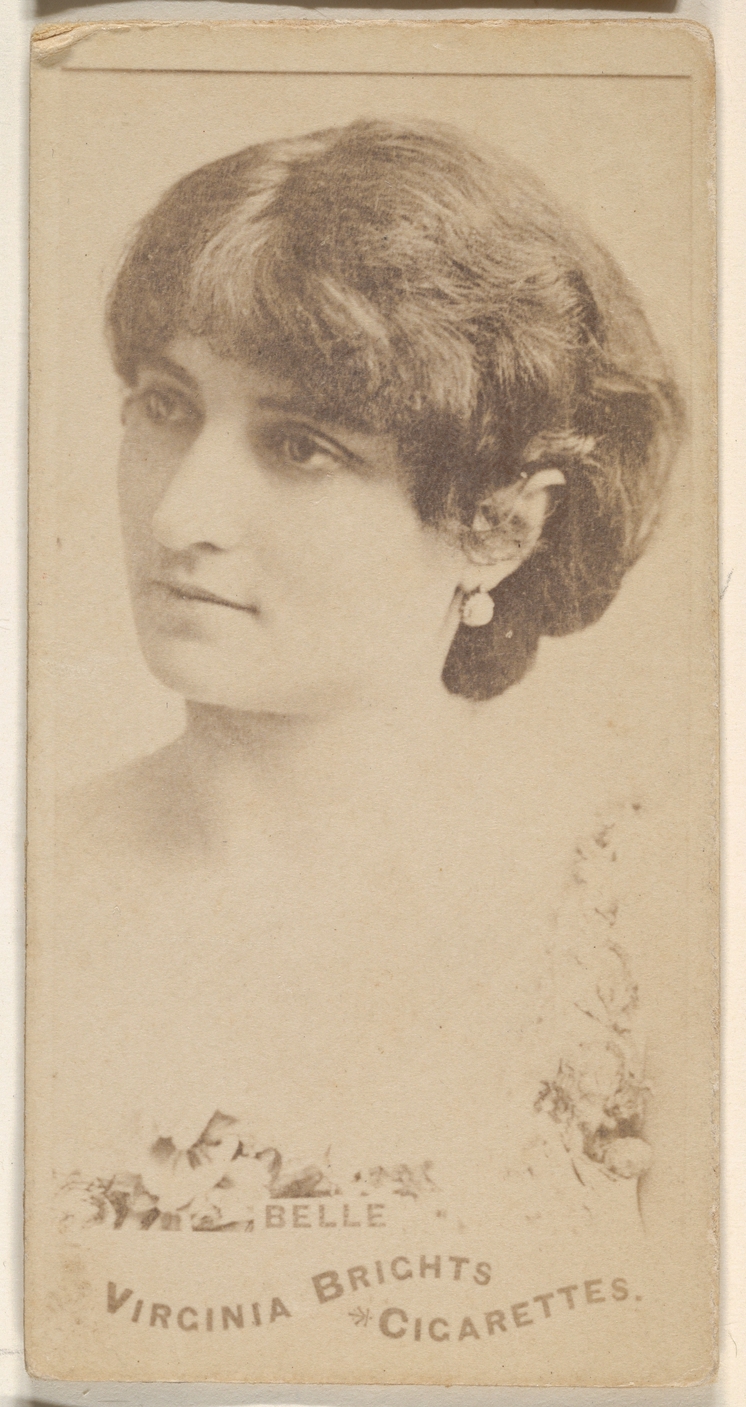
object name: photograph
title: Belle, from the Actors and Actresses series (N45, Type 1) for Virginia Brights Cigarettes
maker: allen & ginter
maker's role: publisher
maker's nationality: american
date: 1888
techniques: albumen silver print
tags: portraits,women,actresses